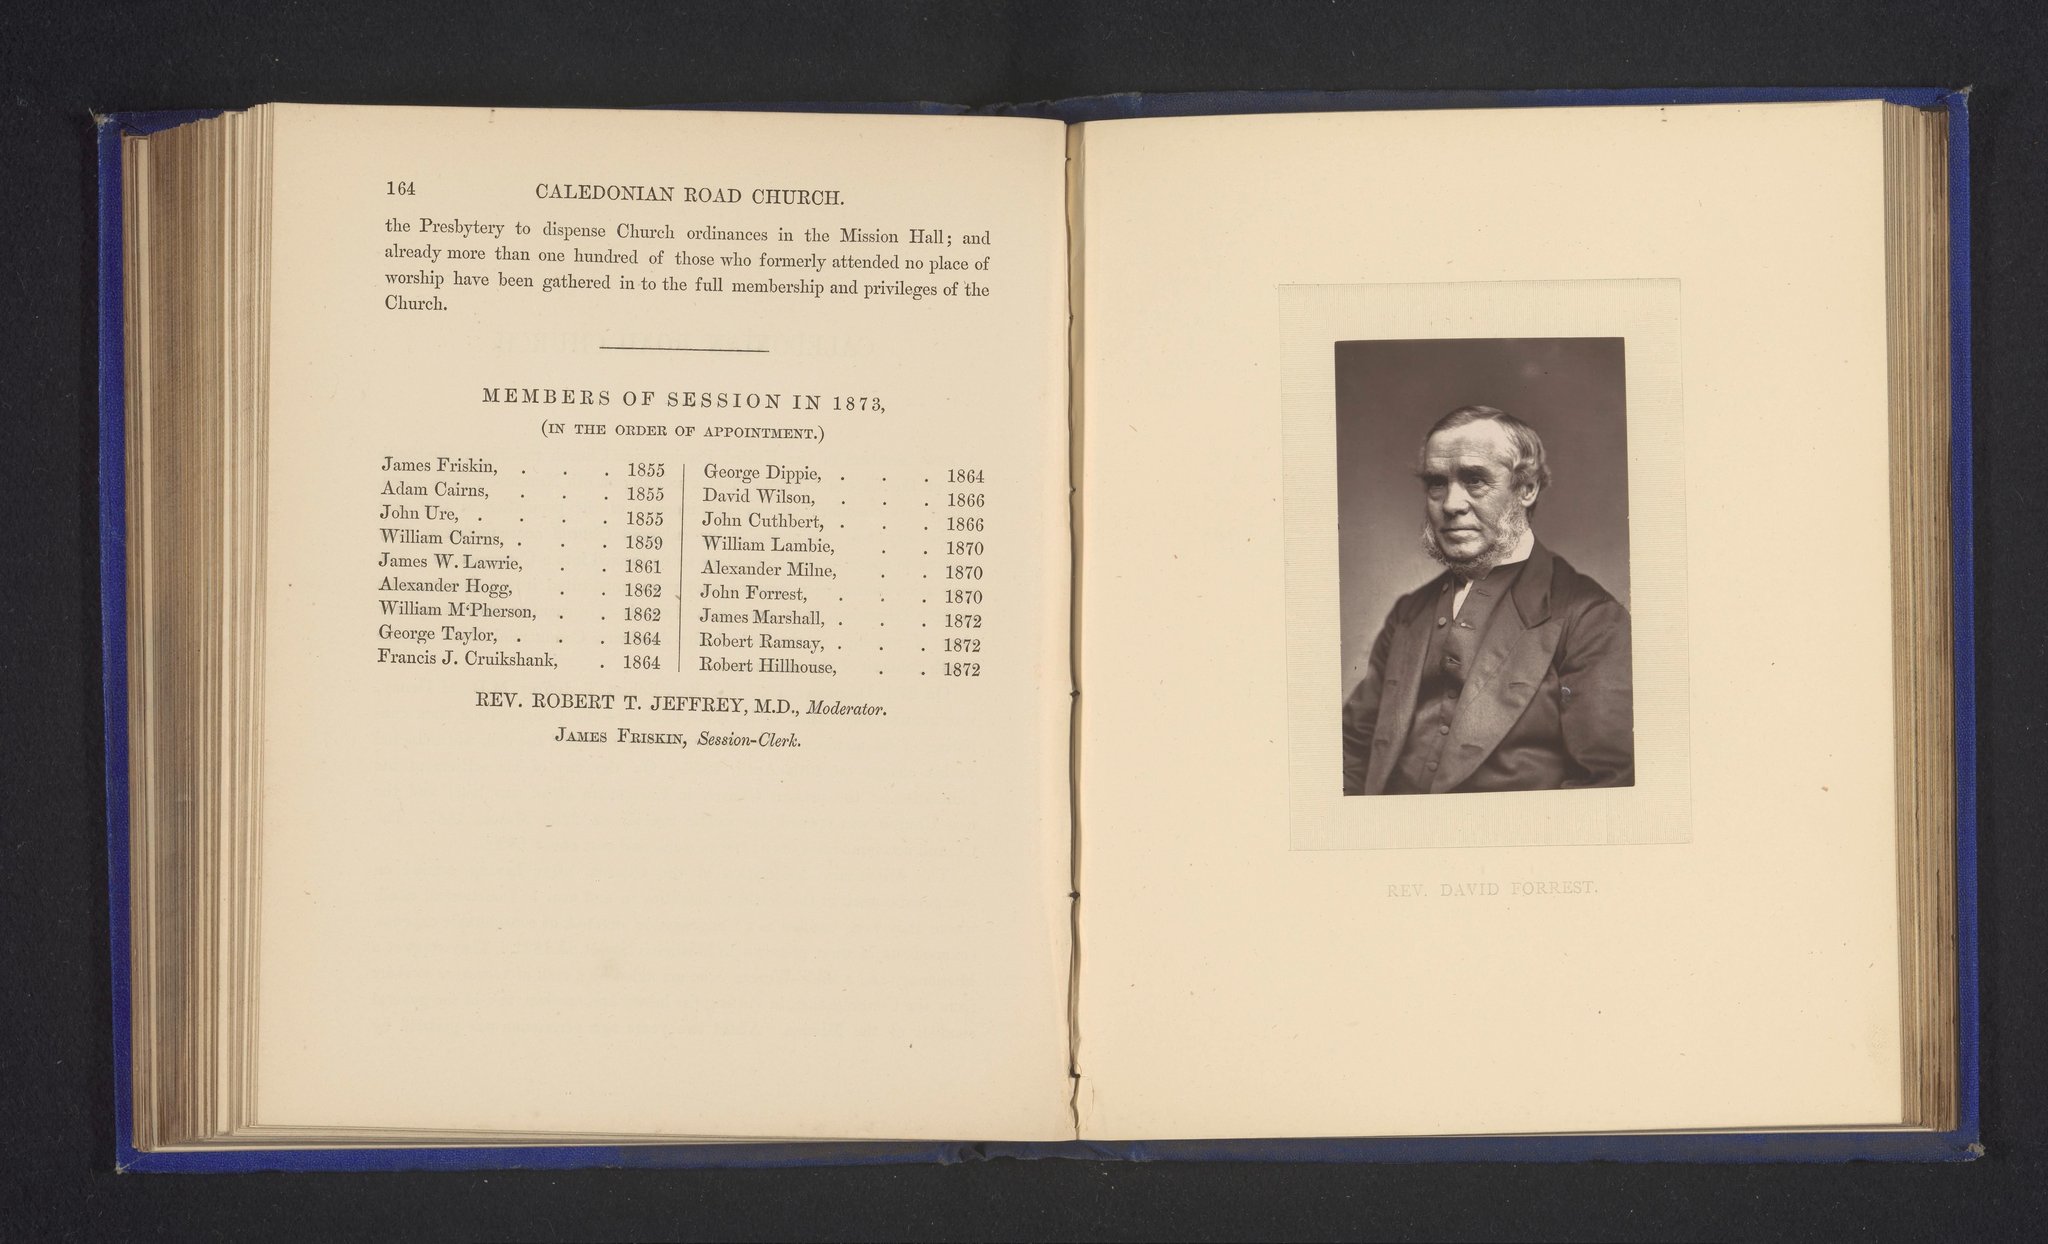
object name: photomechanical print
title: Portret van David Forrest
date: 1865-1875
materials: paper, photographic support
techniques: carbon print, woodburytype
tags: functionaries and dignitaries (with name) ~ protestant churches